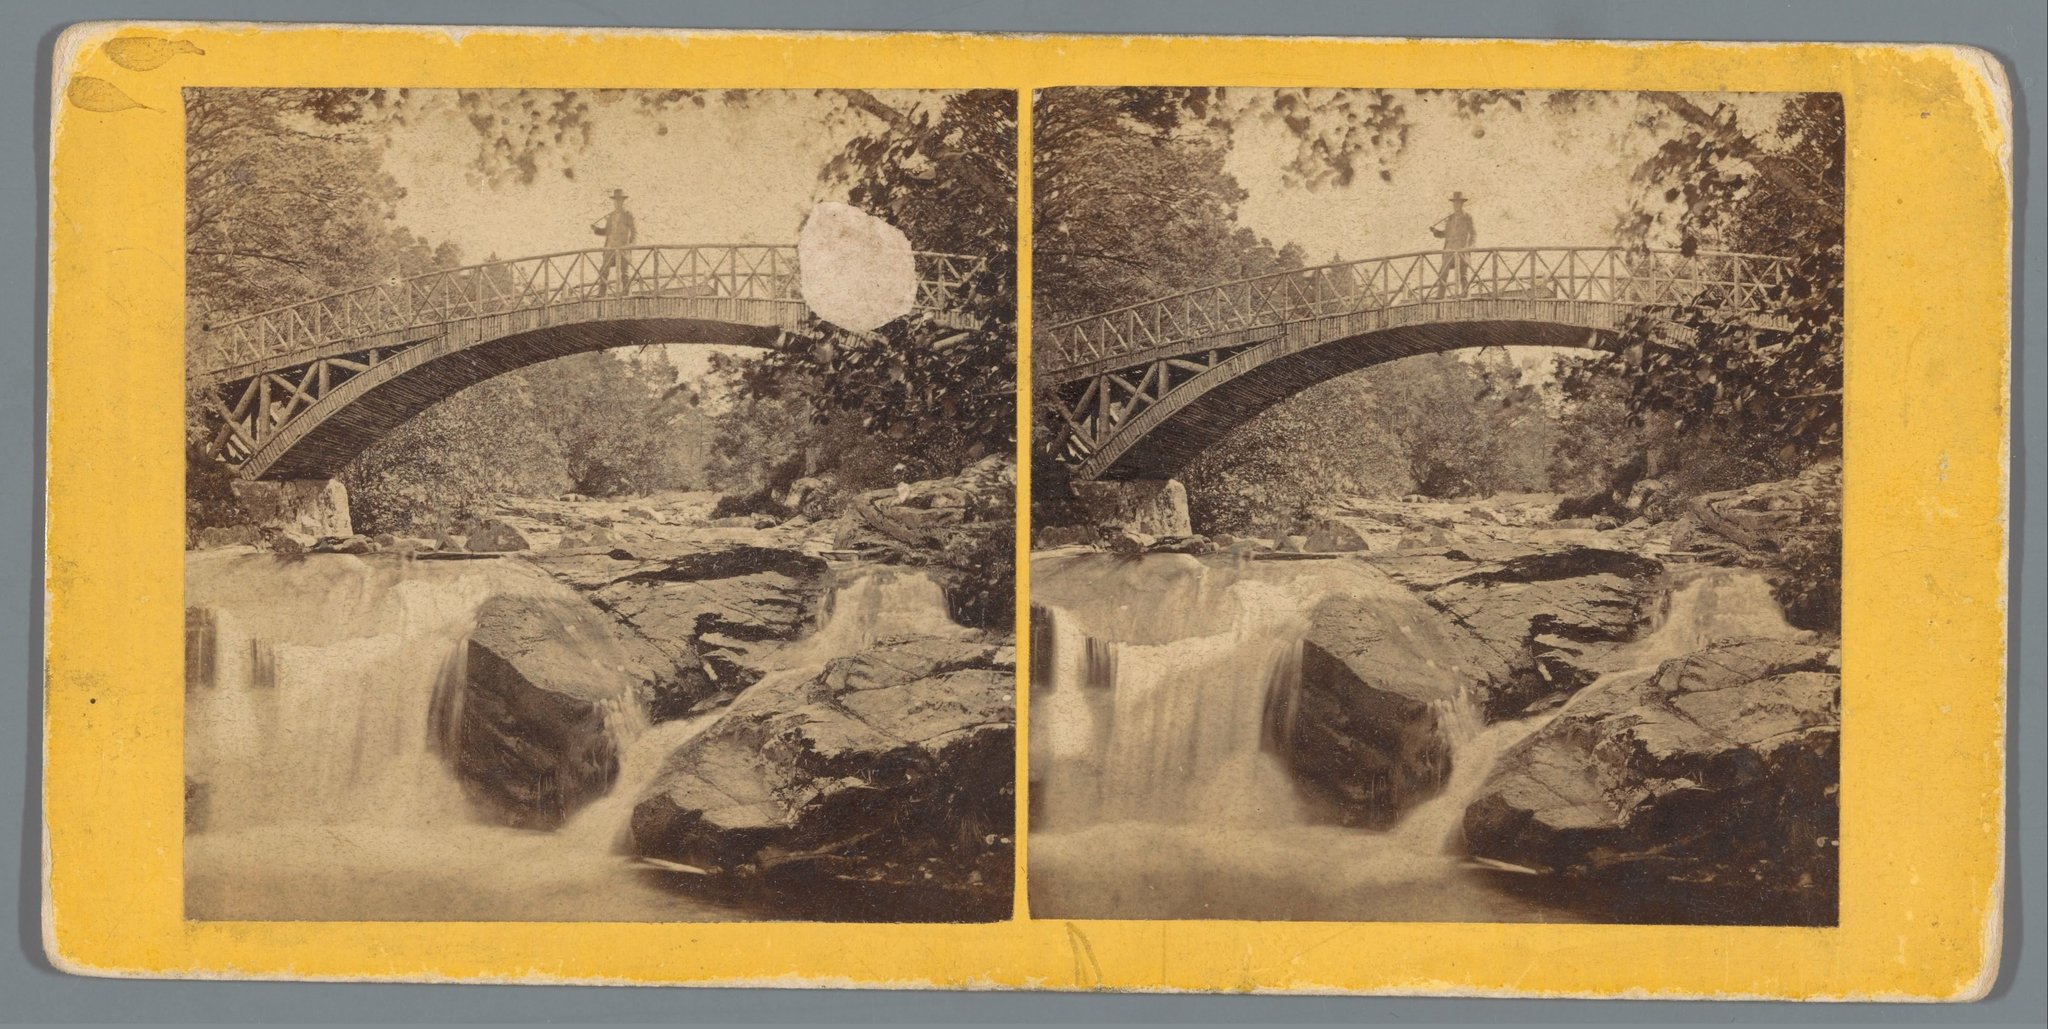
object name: stereograph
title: Upper Fall on the Garr-valt, Braemar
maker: george washington wilson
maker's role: publisher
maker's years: 1823-1893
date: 1860-1865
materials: cardboard, photographic support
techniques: albumen print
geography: aberdeen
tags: schotland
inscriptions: label: ‘G.W. Wilson & Co, Aberdeen No. 44 Upper Fall on the Garr-valt, Braemar’